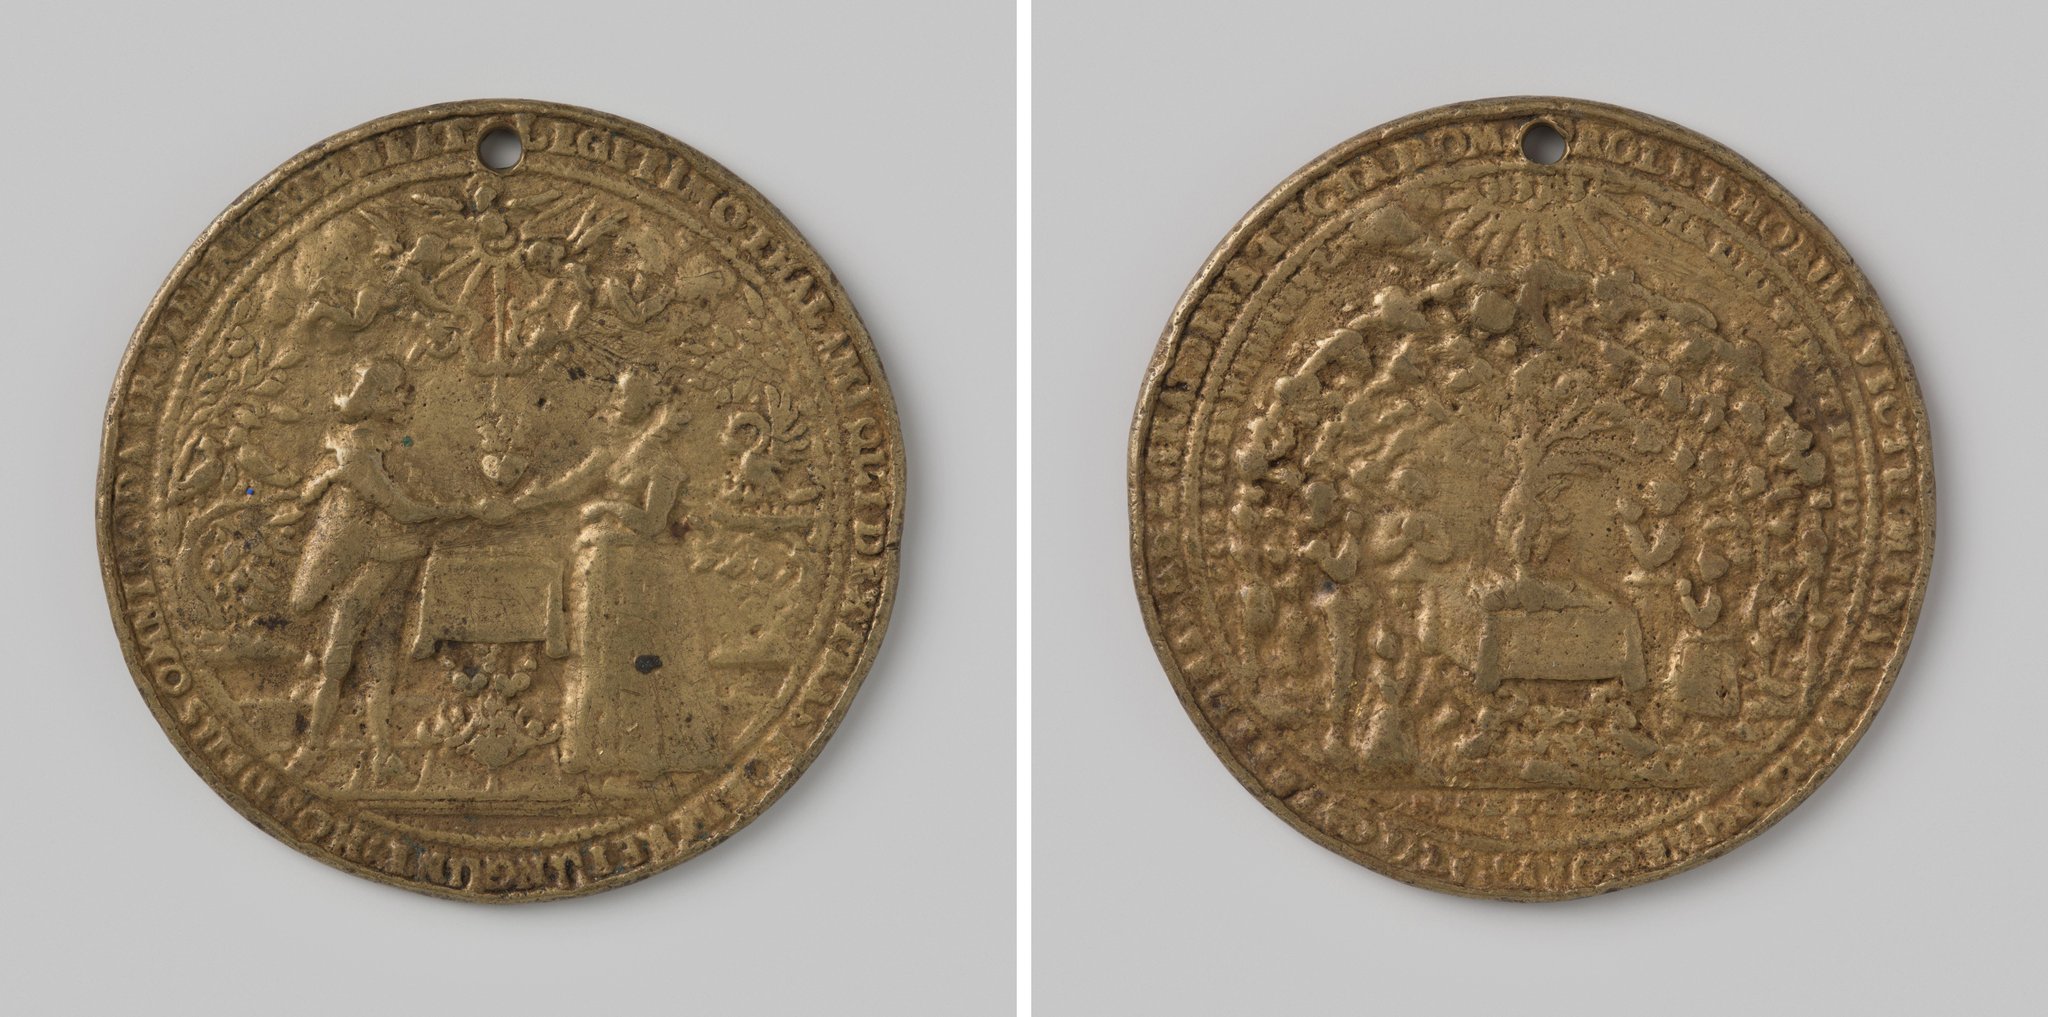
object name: history medal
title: Algemene huwelijkspenning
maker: sebastian dadler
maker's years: 1586-1657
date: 1635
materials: brass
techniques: casting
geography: danzig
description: Messing penning met kleine doorboring, op de voorzijde man en vrouw die elkaars hand drukken boven een altaar te midden van liefdessymbolen, met omschrift, op de keerzijde een gezin biddend rond een gedekte tafel onder een pergola, met omschrift en afsnedetekst. Grove gieting.